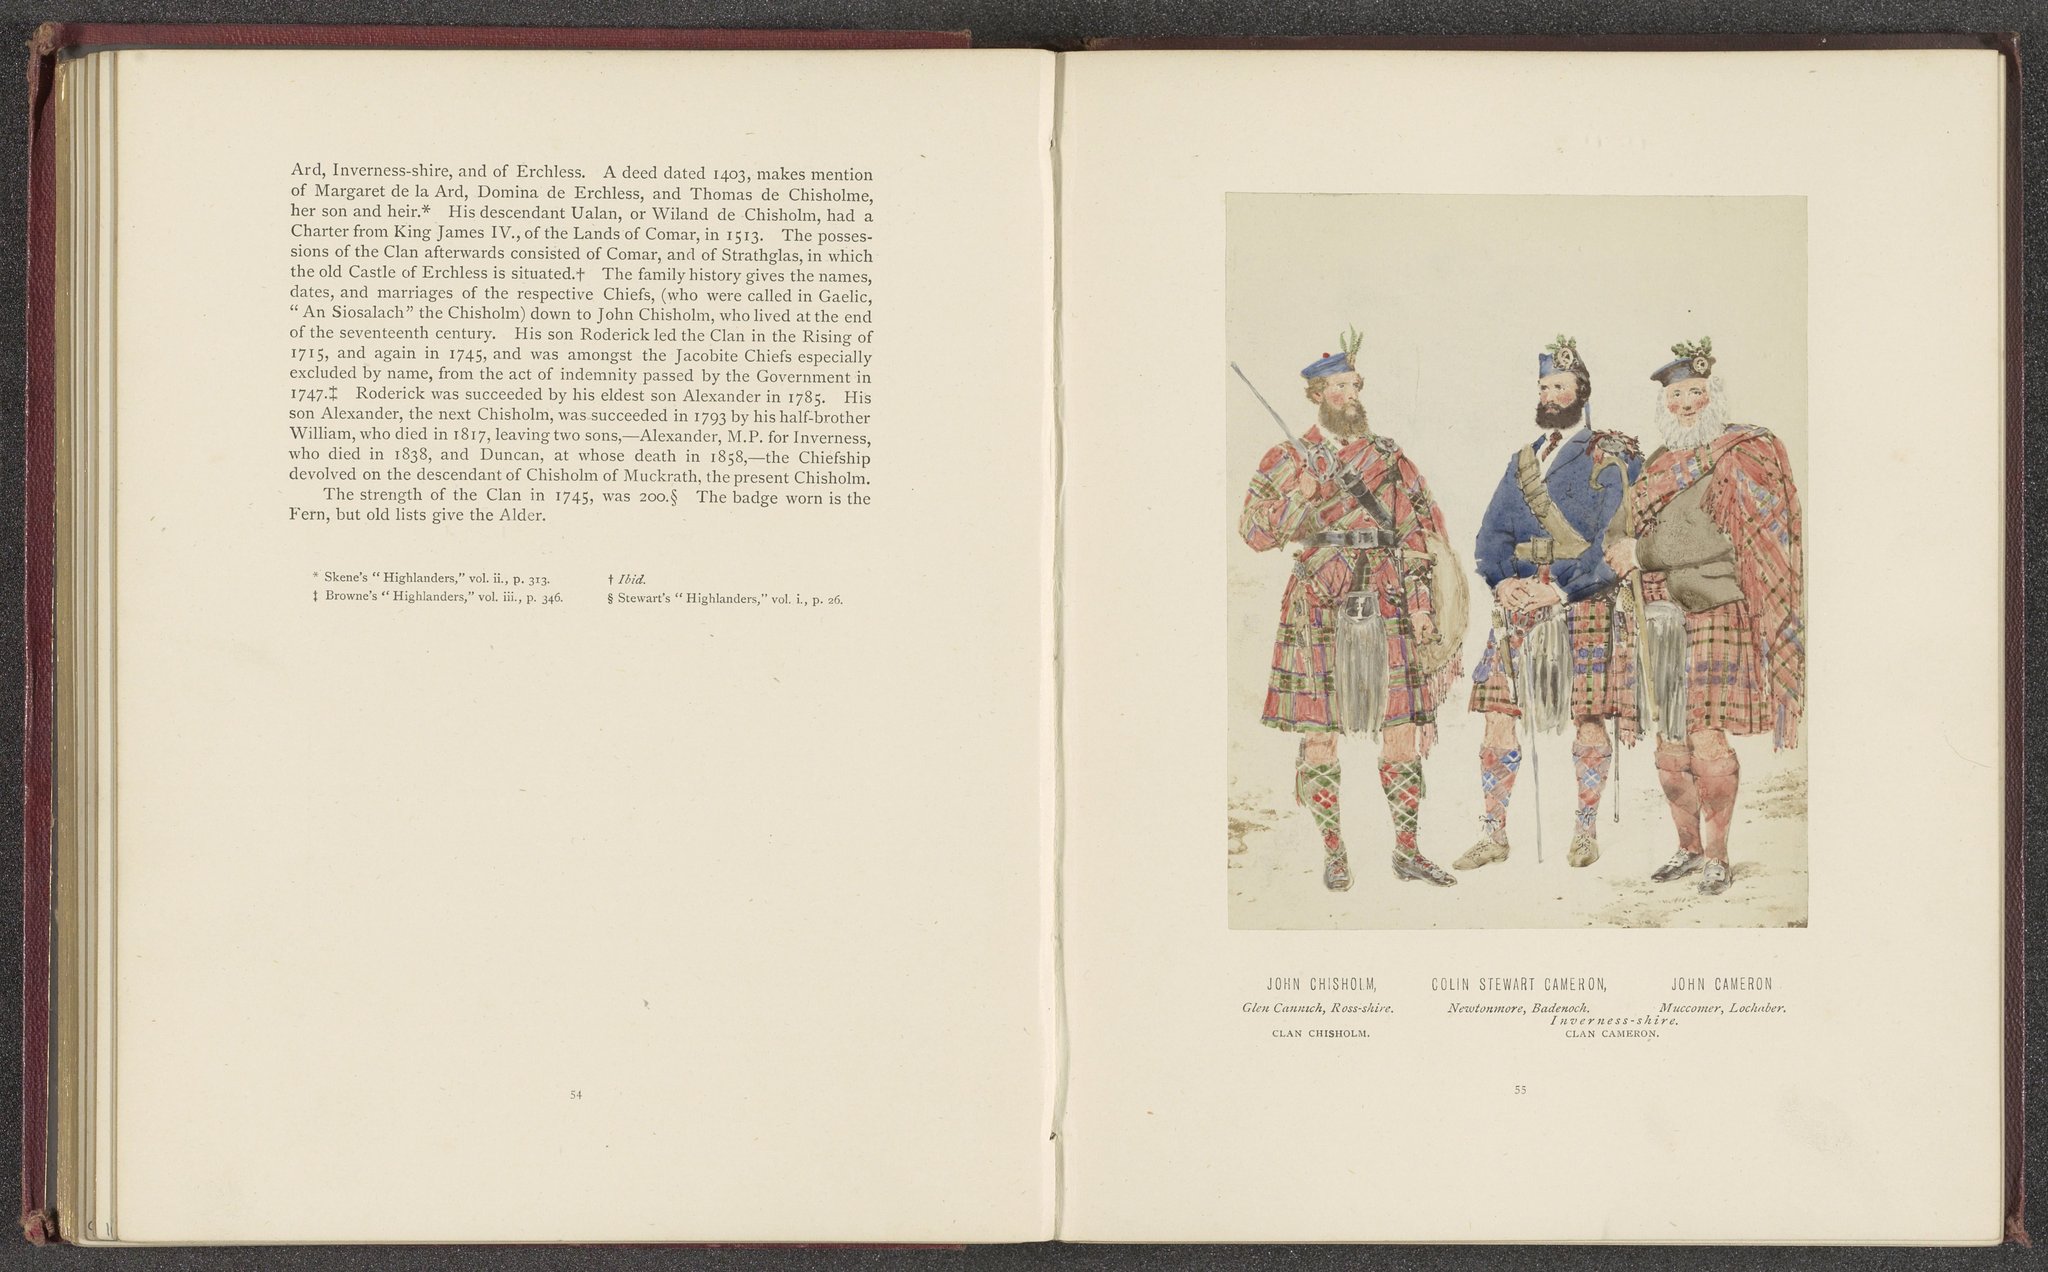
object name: page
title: John Chisholm, Glen Cannuch, Ross-shire, Clan Chisholm. Colin Stewart Cameron, Newtonmore, Badenoch. John Cameron Muccomer, Lochaber. Iverness-shire. Clan Cameron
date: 1860-1870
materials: photographic support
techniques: albumen print, hand coloring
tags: adult man, hacking and thrusting weapons: sword, folk costume, regional costume